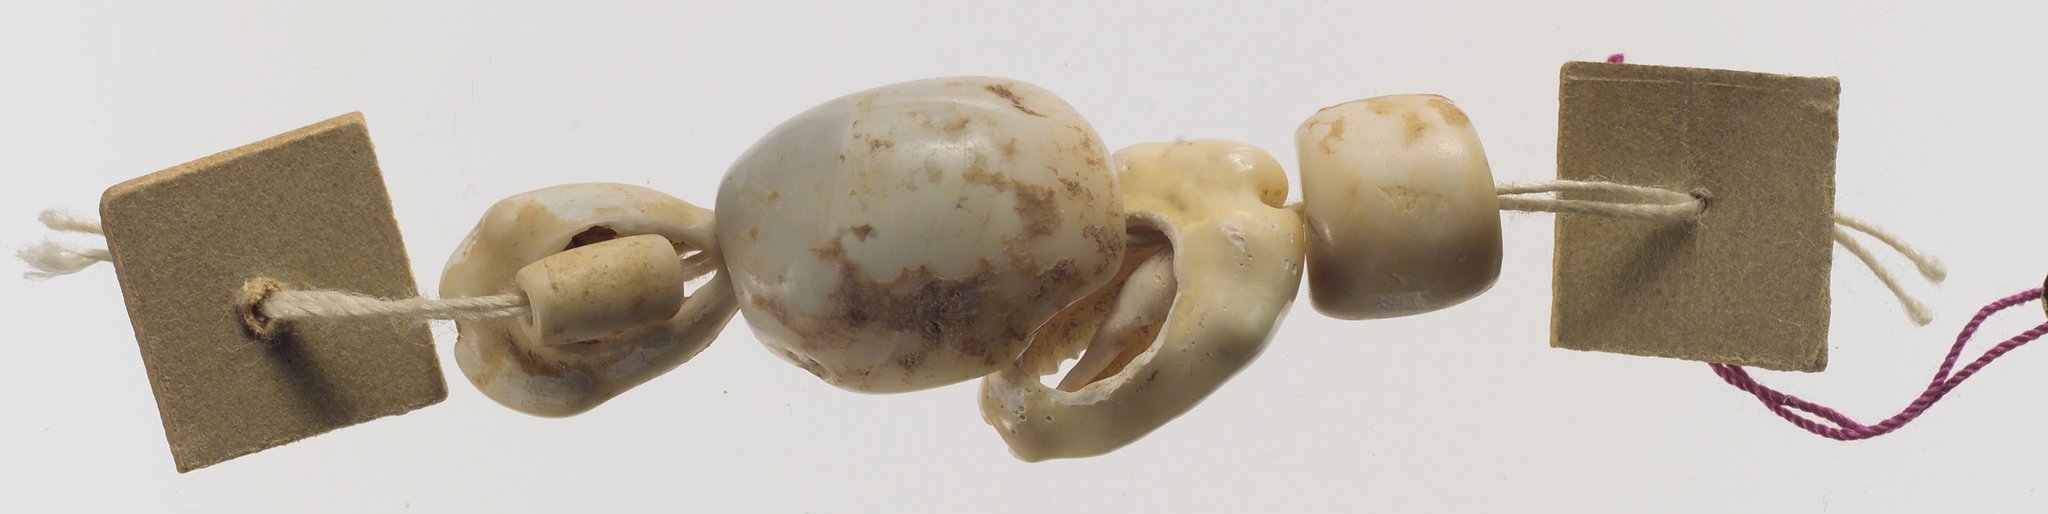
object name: bead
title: Shell beads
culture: sasanian or islamic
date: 501-800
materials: shell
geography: iran